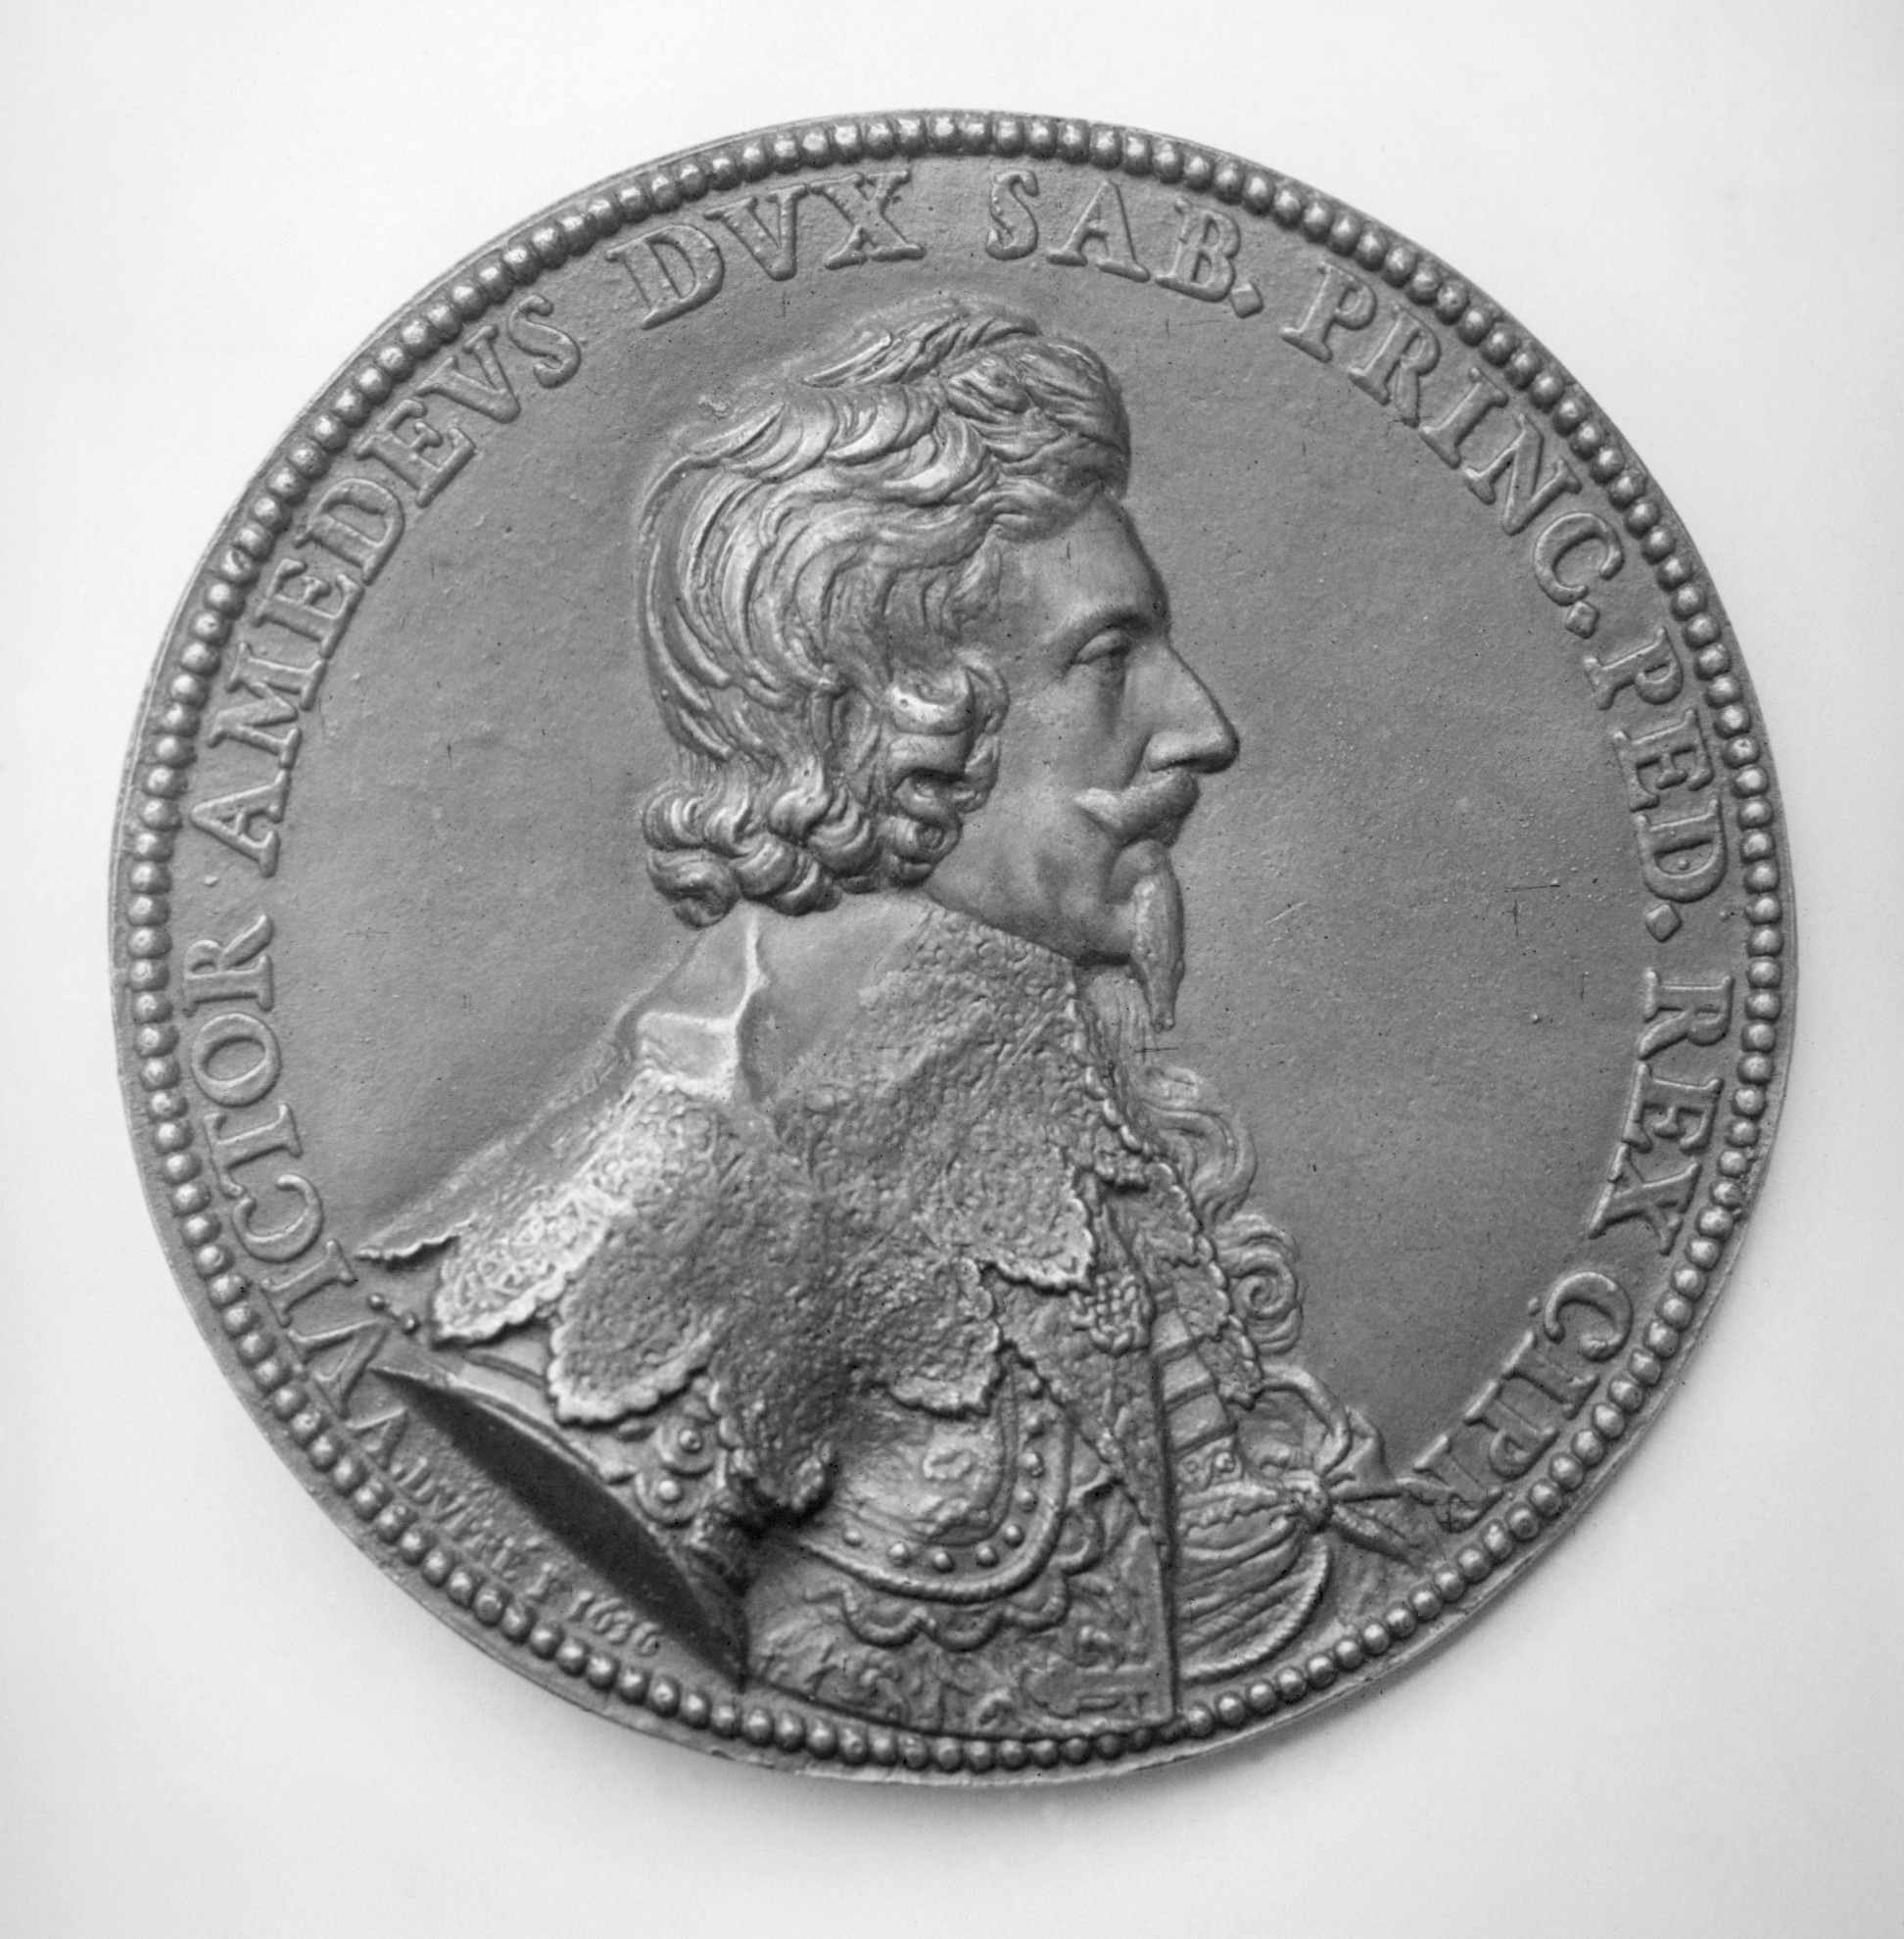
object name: medal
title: Victor Amadeus I, Duke of Savoy (1587–1637)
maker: abraham dupré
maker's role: artist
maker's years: 1604-1647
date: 1601-1700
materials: bronze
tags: men,profiles,women